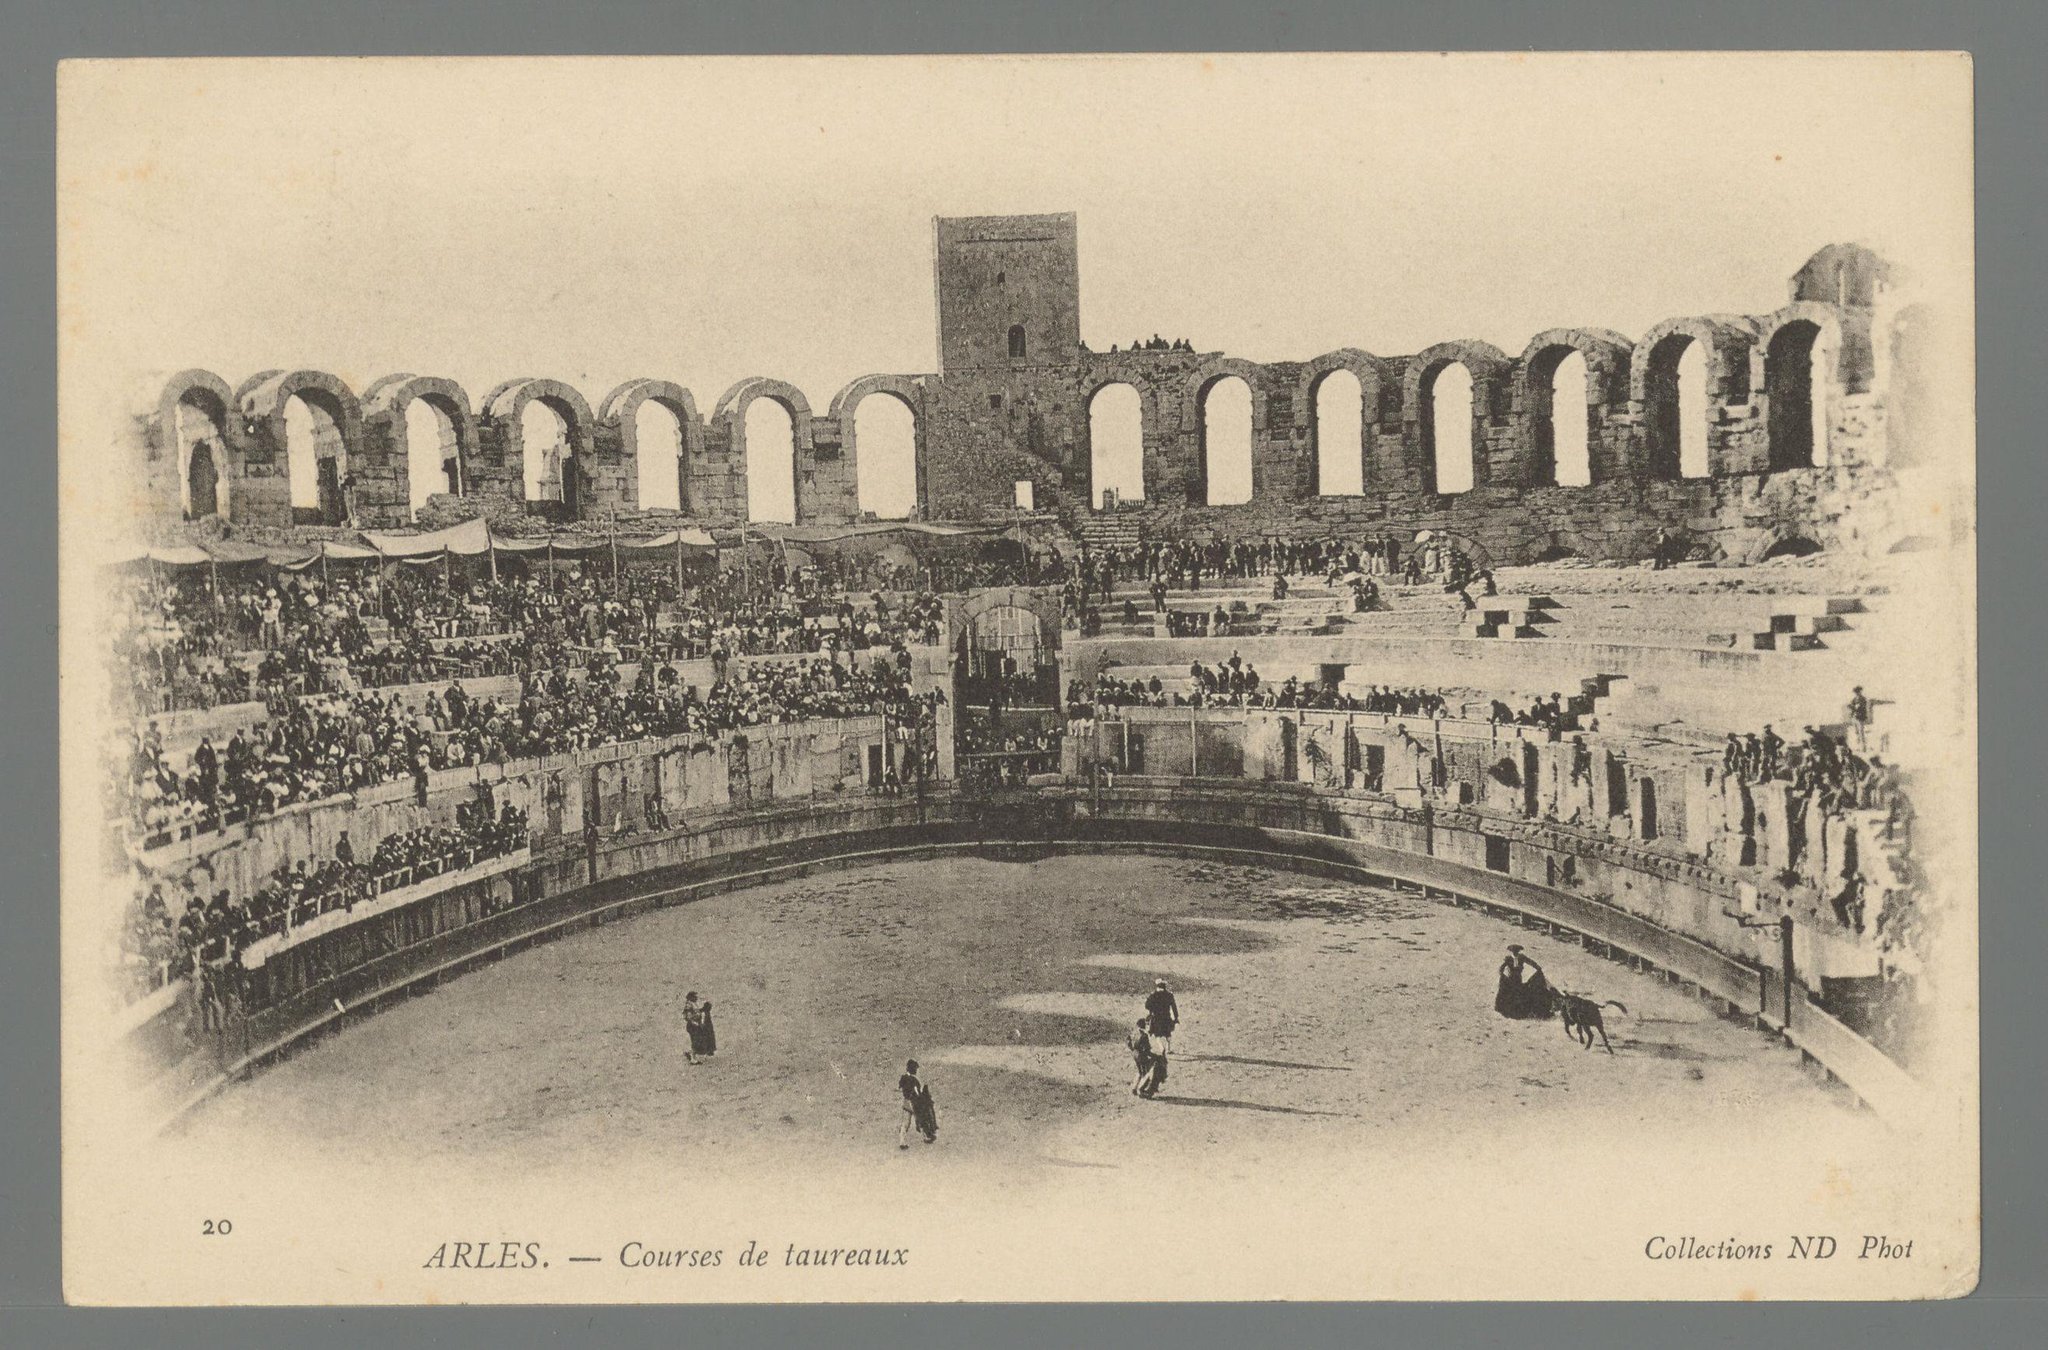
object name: photomechanical print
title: Arles. Courses de taureaux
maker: Anonymous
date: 1892-1903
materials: cardboard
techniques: photograph, writing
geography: arles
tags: bullfight, theatre (building) - aa - open-air performances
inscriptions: postage stamp